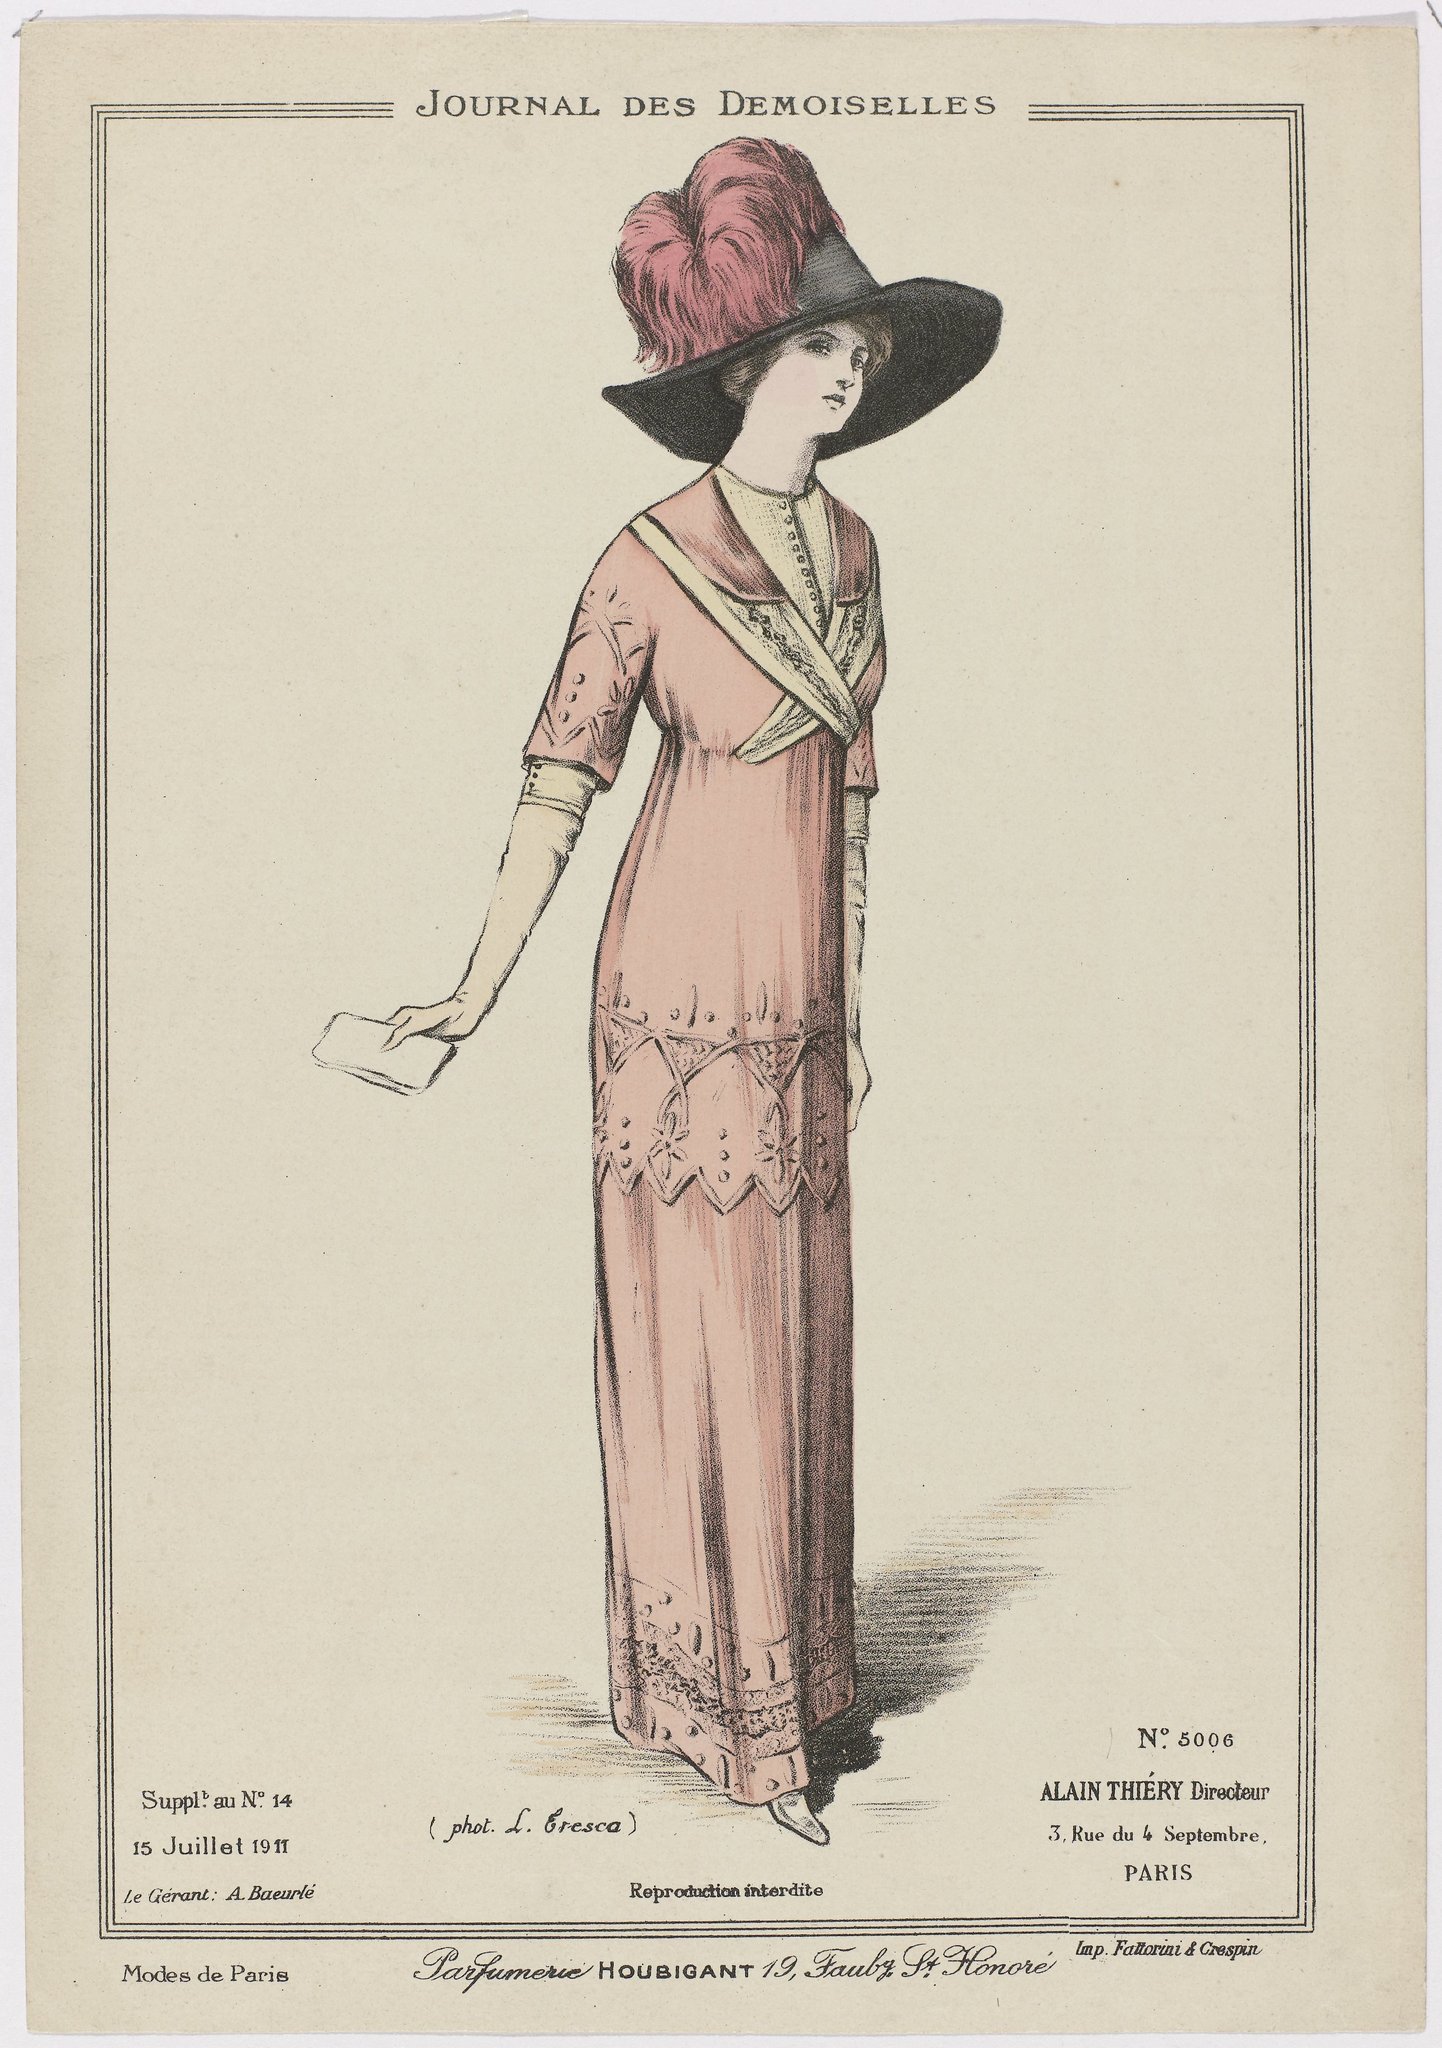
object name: fashion print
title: Journal des Demoiselles, Supplement au No. 14, 15 Juillet 1911, No. 5006 : Parfumerie Houbigant (...)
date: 1911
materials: paper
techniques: hand coloring, lithograph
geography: paris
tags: fashion plates, head-gear: hat (+ women's clothes), dress, gown (+ women's clothes), letter, envelope, head-gear: hat (+ feathers used for clothes)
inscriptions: title: ‘Modes de Paris’, title: ‘JOURNAL DES DEMOISELLES’, caption: ‘Parfumerie HOUBIGANT 19, Faub.g S.t Honoré’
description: Vrouw in een japon met hoge taille en halflange mouwen. Mouwen, heup en zoom versierd met bloem-, stippen- en zig-zag-motief. Grote hoed met brede rand en verenpluim. Brief in de hand. Prent uit het modetijdschrift Journal des Demoiselles (1833 -1922).